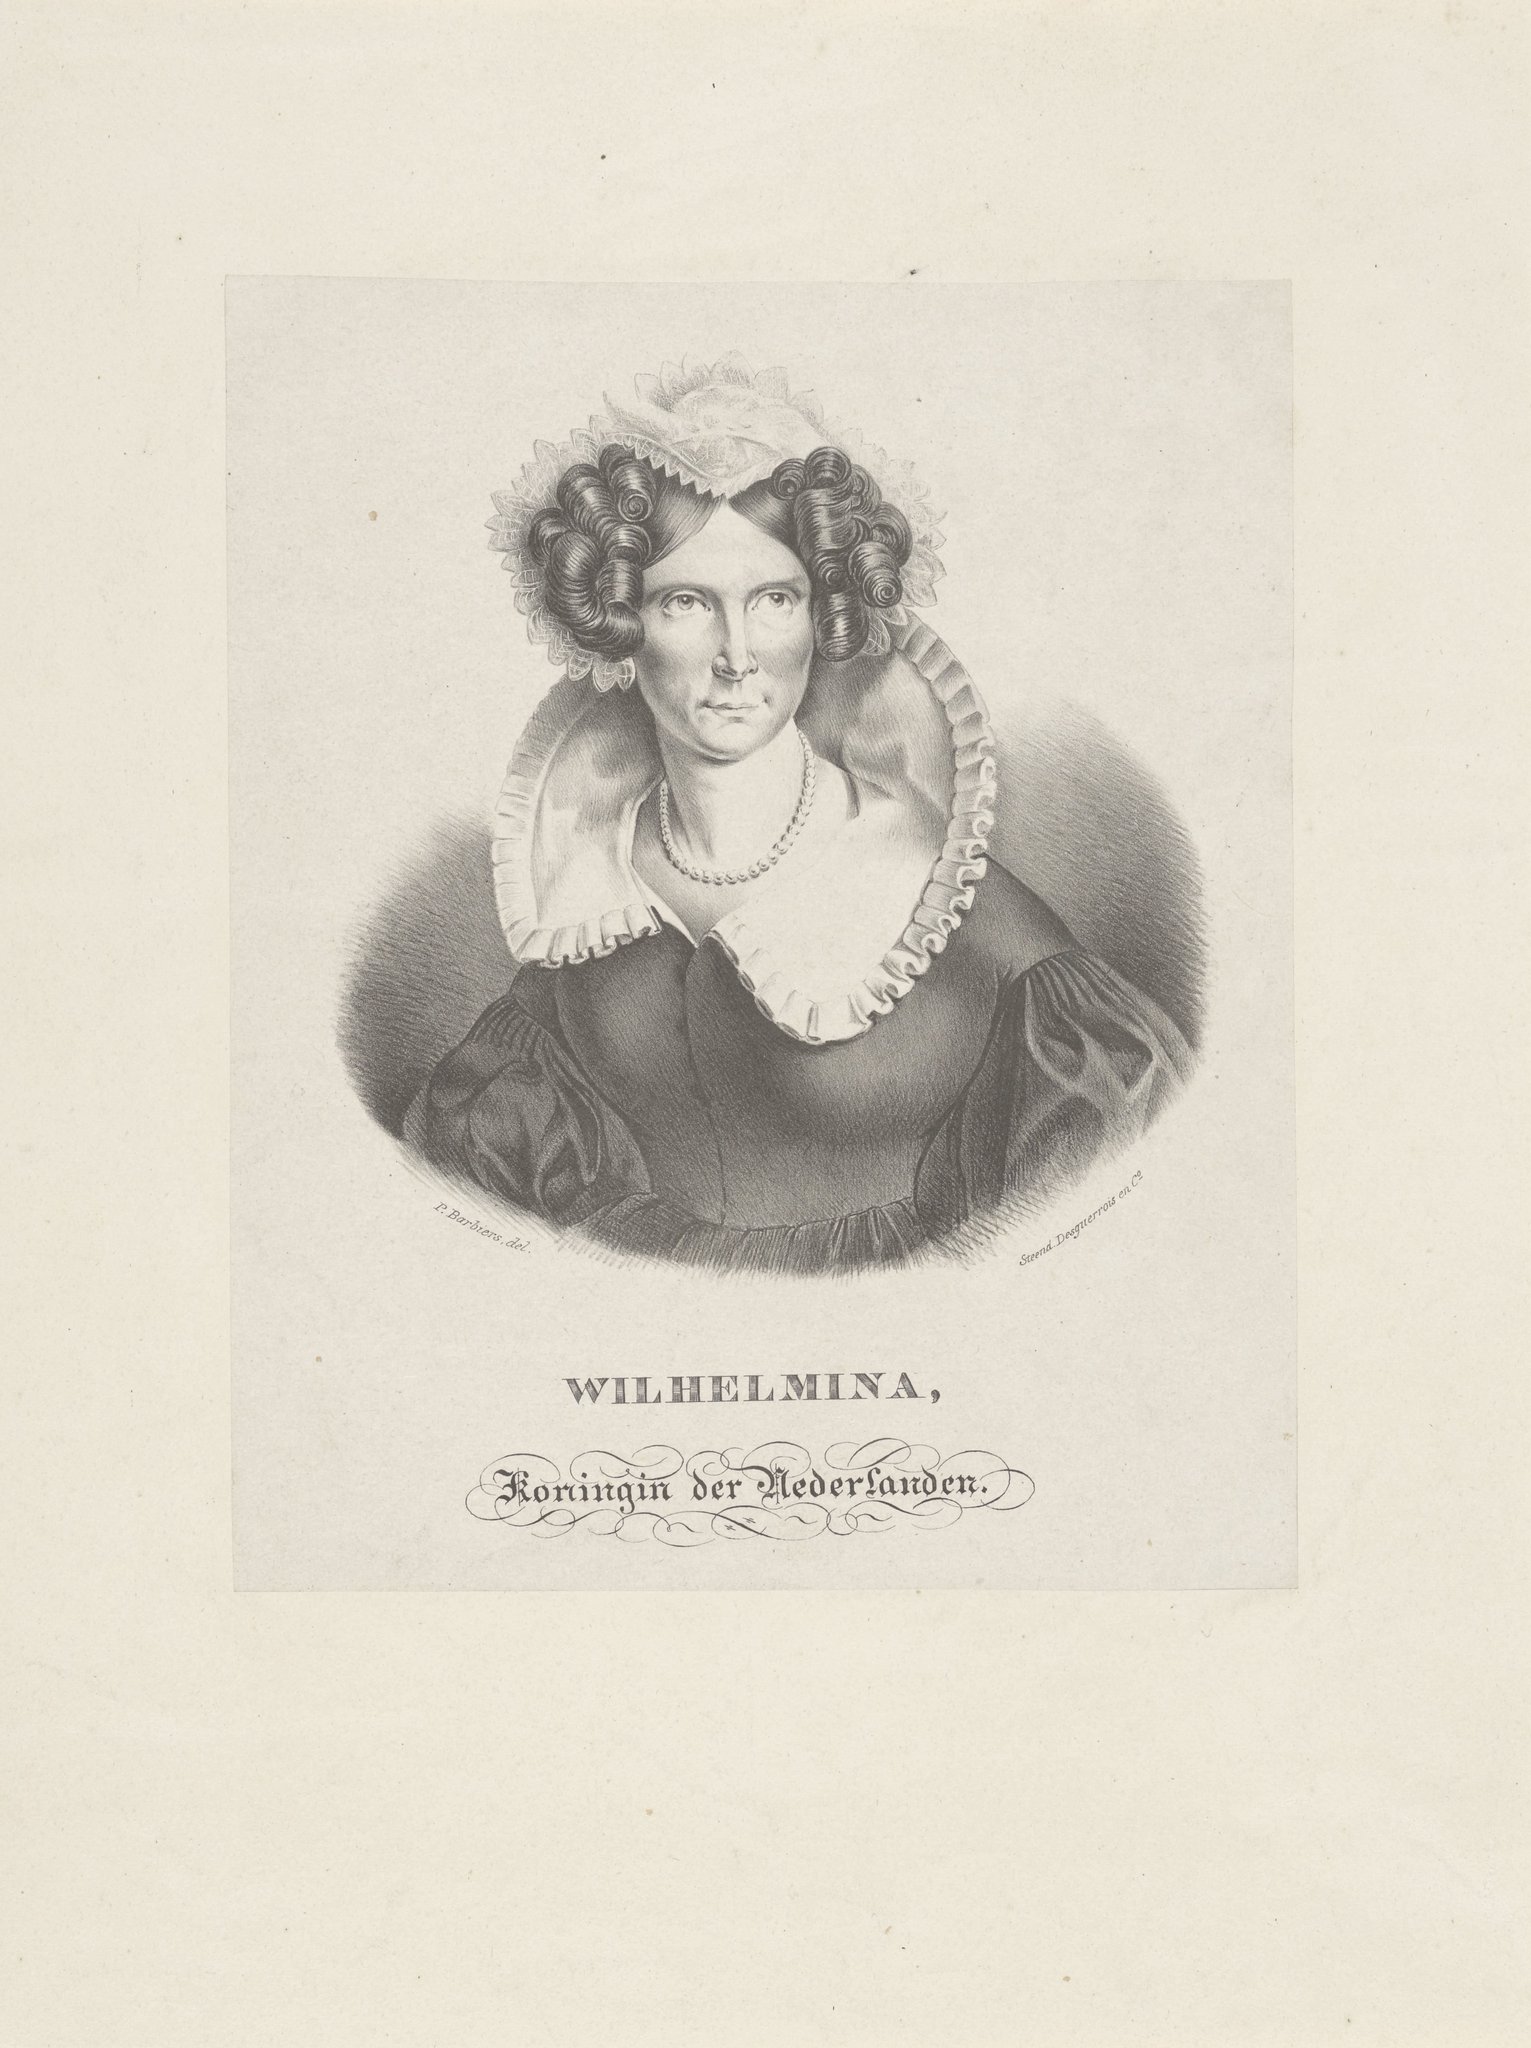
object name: print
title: Portret van Wilhelmina van Pruisen, koningin der Nederlanden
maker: pieter barbiers (iv)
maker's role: painter, print maker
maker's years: 1798-1848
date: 1808-1848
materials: paper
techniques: lithograph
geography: amsterdam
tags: the hague, wilhelmina frederica louisa (koningin der nederlanden), historical persons - bb - woman, pearl; pearl necklace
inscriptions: collector's mark: Lugt 2760, collector's mark: Lugt 2228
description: De geportretteerde draagt een opstaande kraag, muts en parelketting.